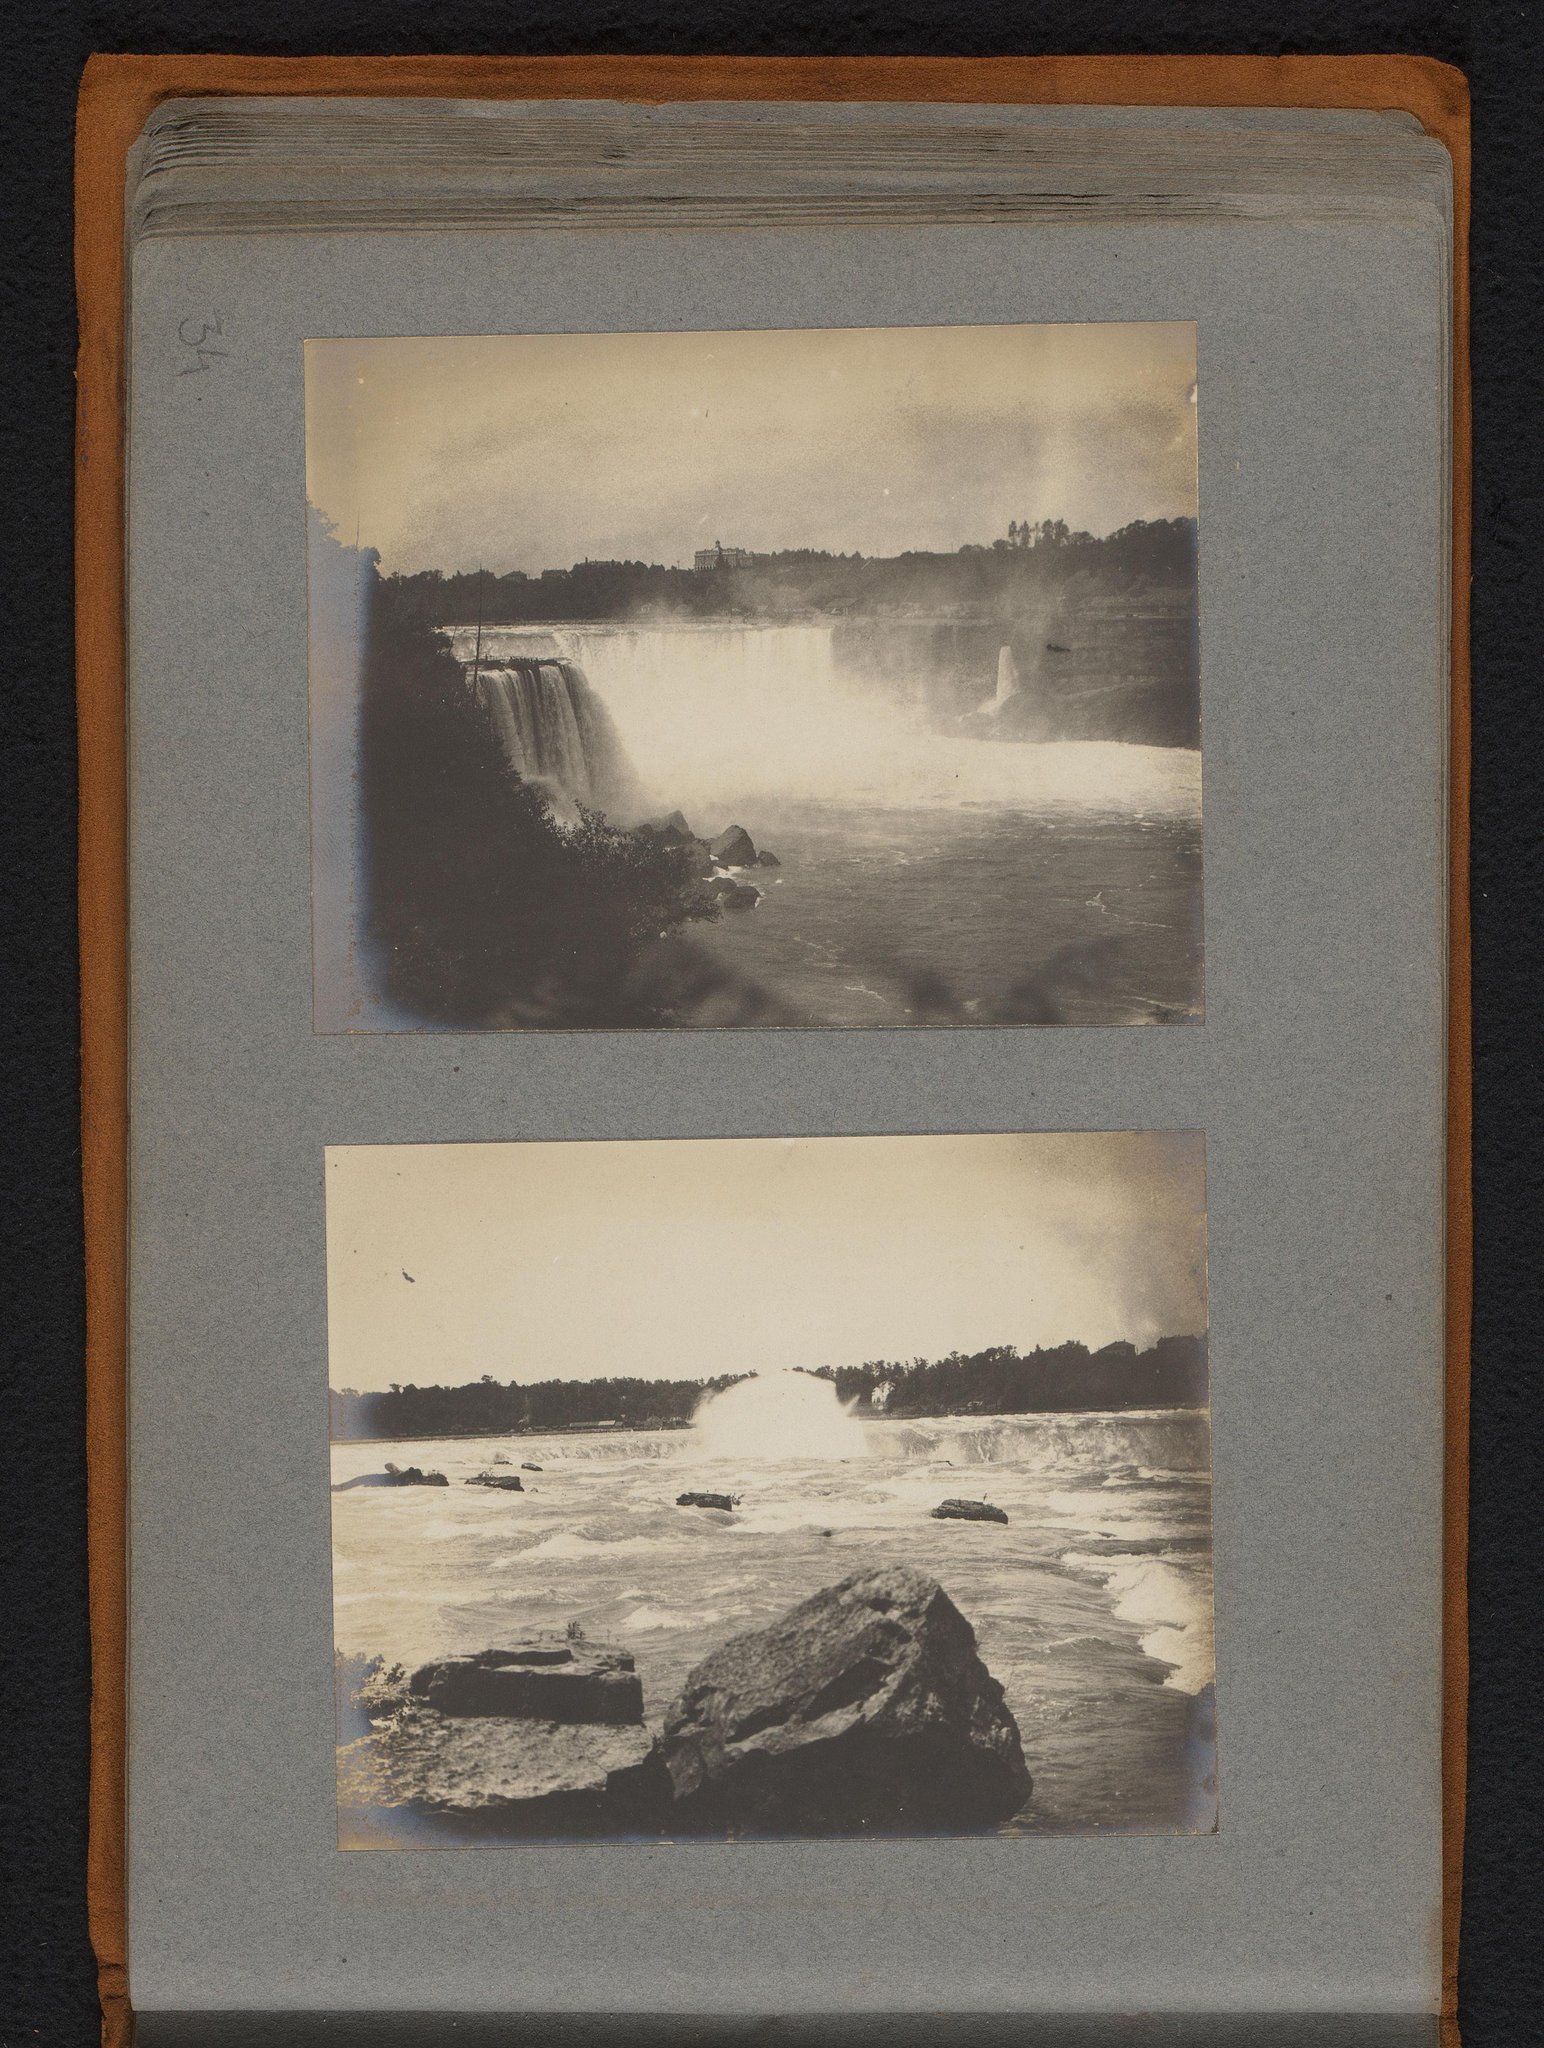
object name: album leaf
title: Gezicht op de Niagarawatervallen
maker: jan van der mey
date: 1902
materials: paper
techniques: gelatin silver print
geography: niagara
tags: waterfall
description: Deze foto's maken deel uit van een album.